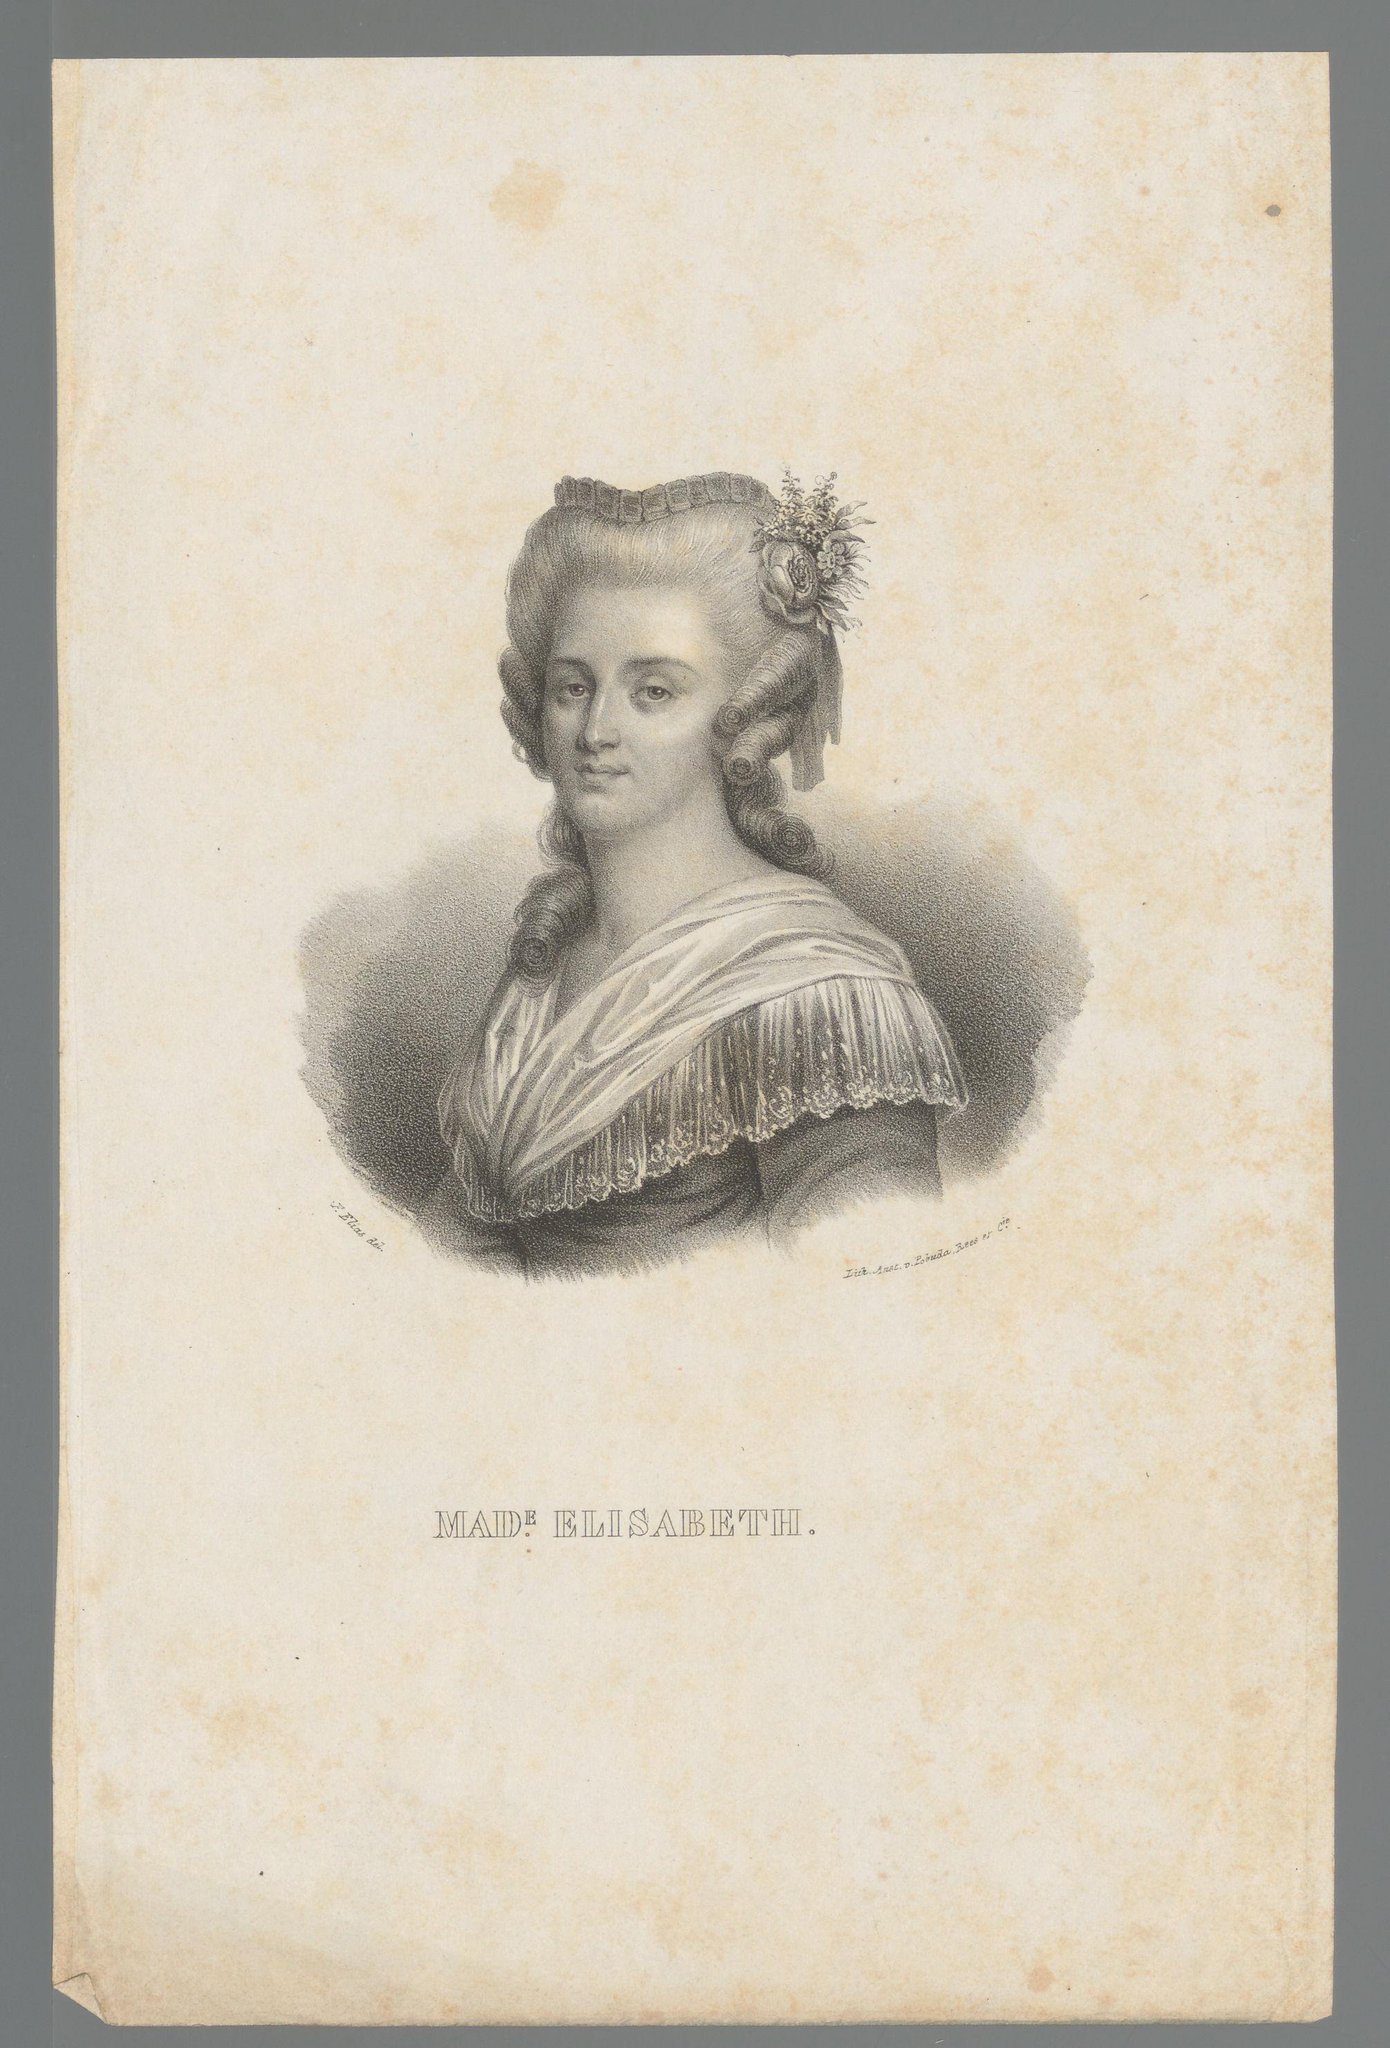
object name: print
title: Portret van een onbekende vrouw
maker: f. elias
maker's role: print maker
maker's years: -1846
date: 1833-1846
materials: paper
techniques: lithograph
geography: stuttgart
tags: adult woman, historical persons not known by name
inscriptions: collector's mark: Lugt 2228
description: Portret van een verder onbekende vrouw met de naam Madame Elisabeth.